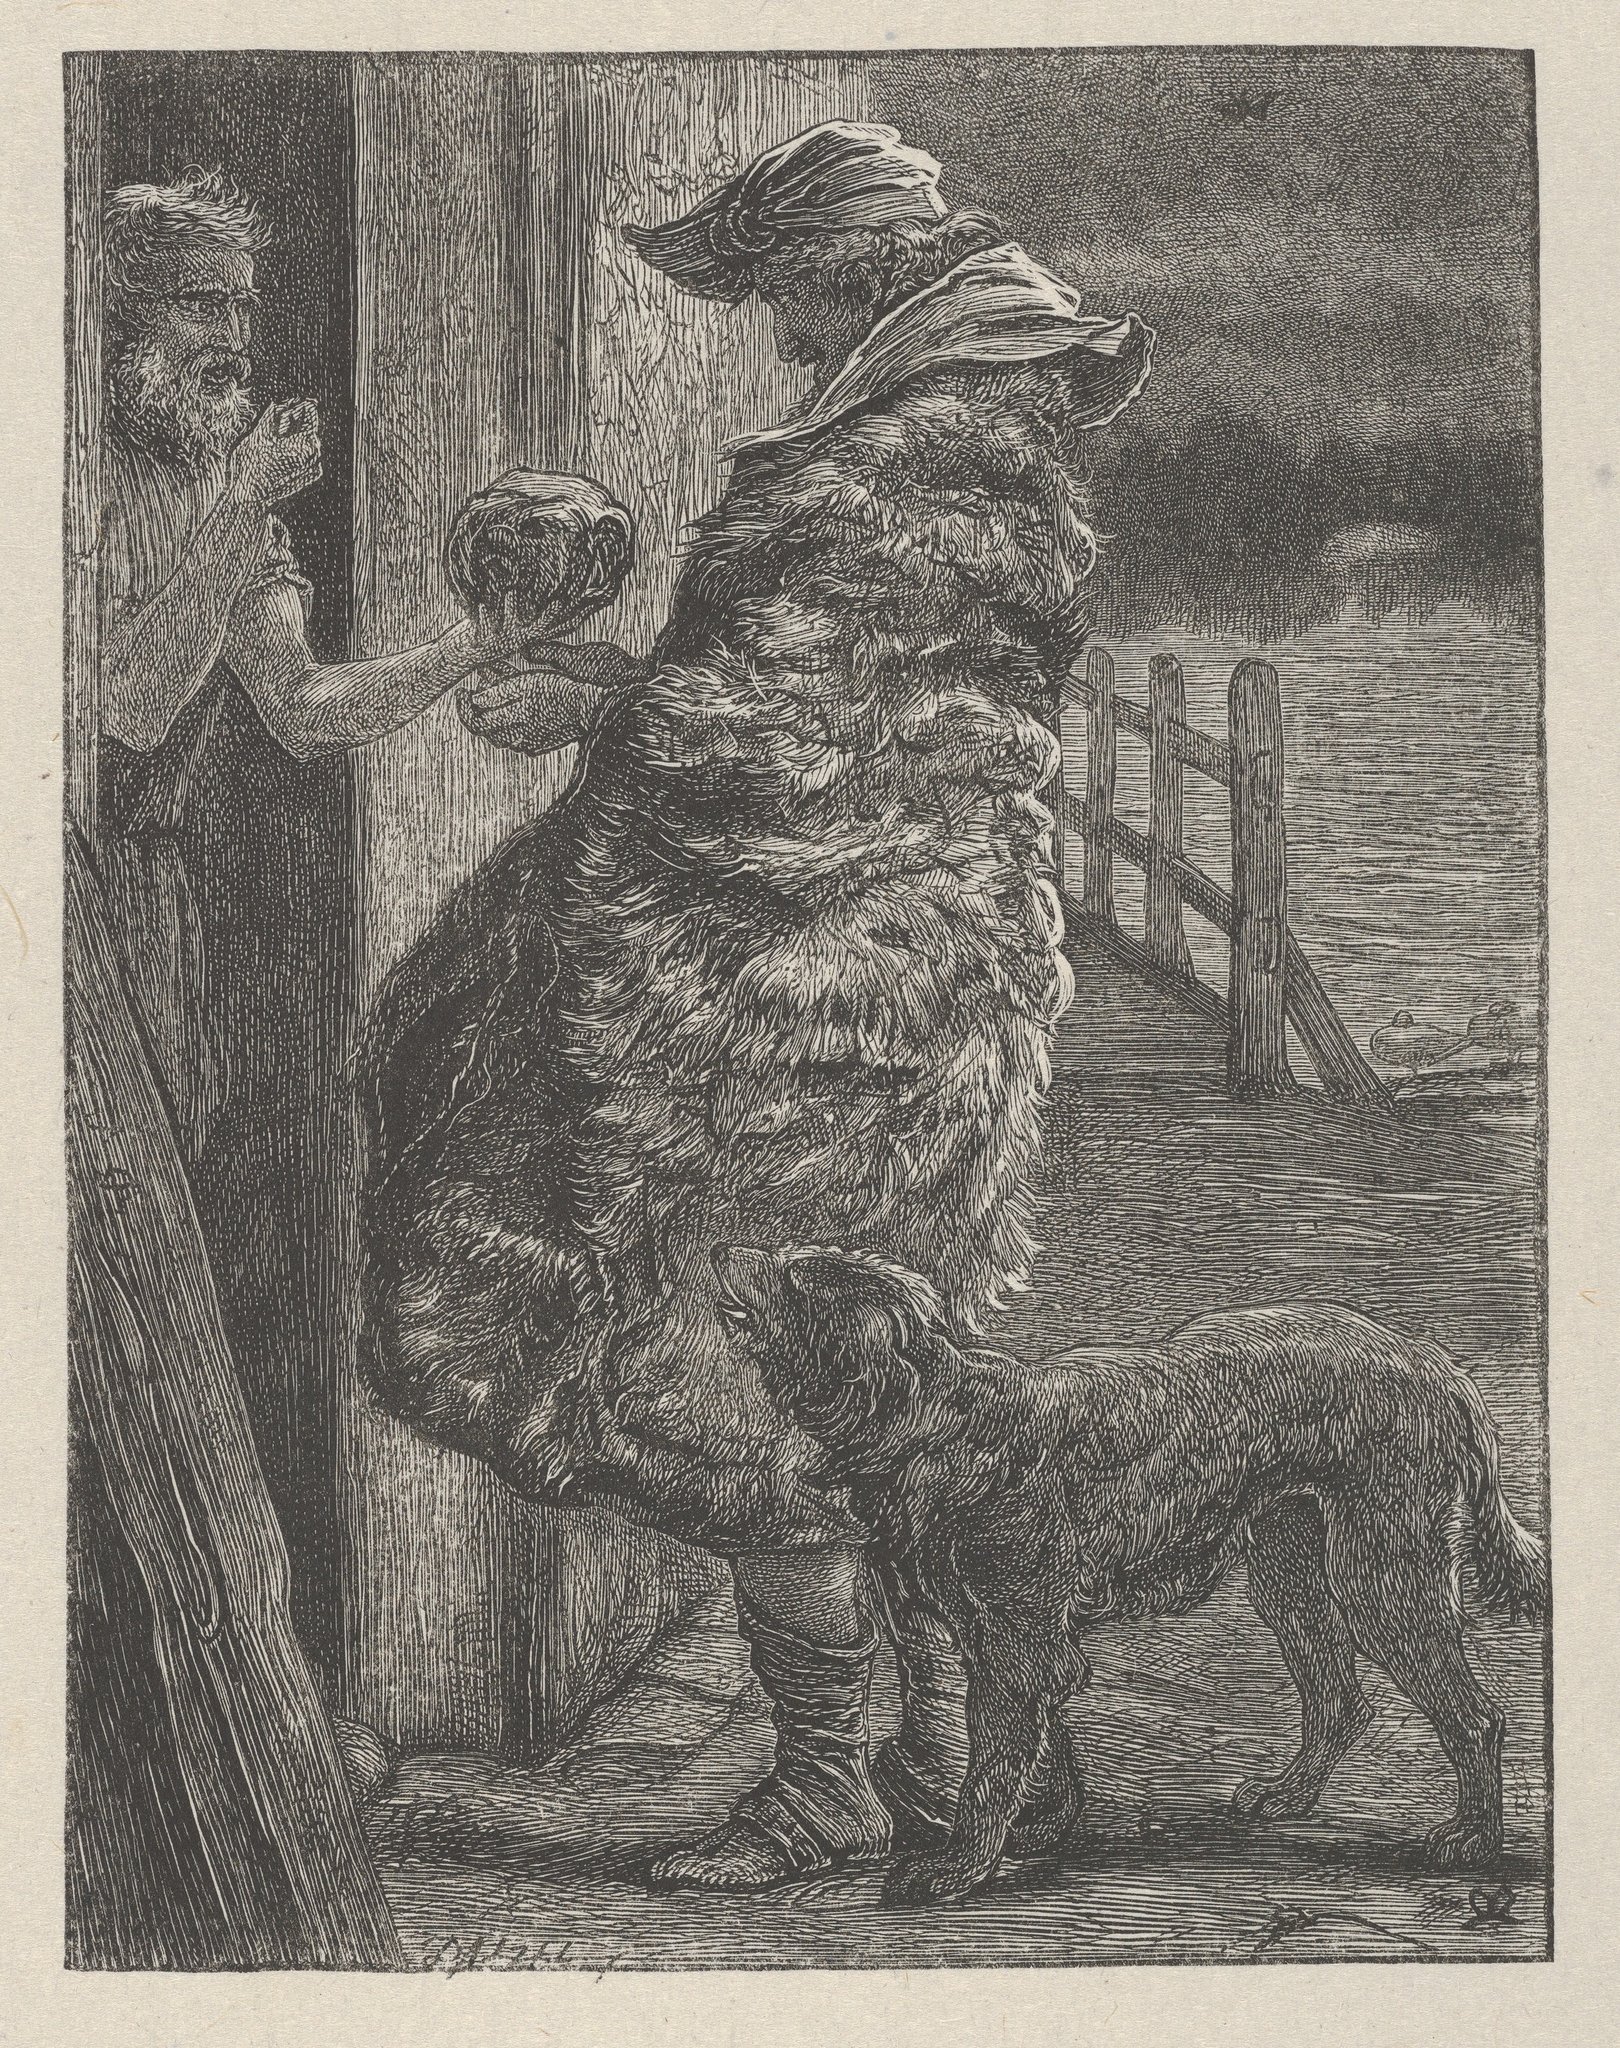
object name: print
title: The Importunate Friend (The Parables of Our Lord and Saviour Jesus Christ)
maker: sir john everett millais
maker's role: artist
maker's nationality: british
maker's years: 1829-1896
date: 1864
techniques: engraving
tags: houses,men,dogs,parables